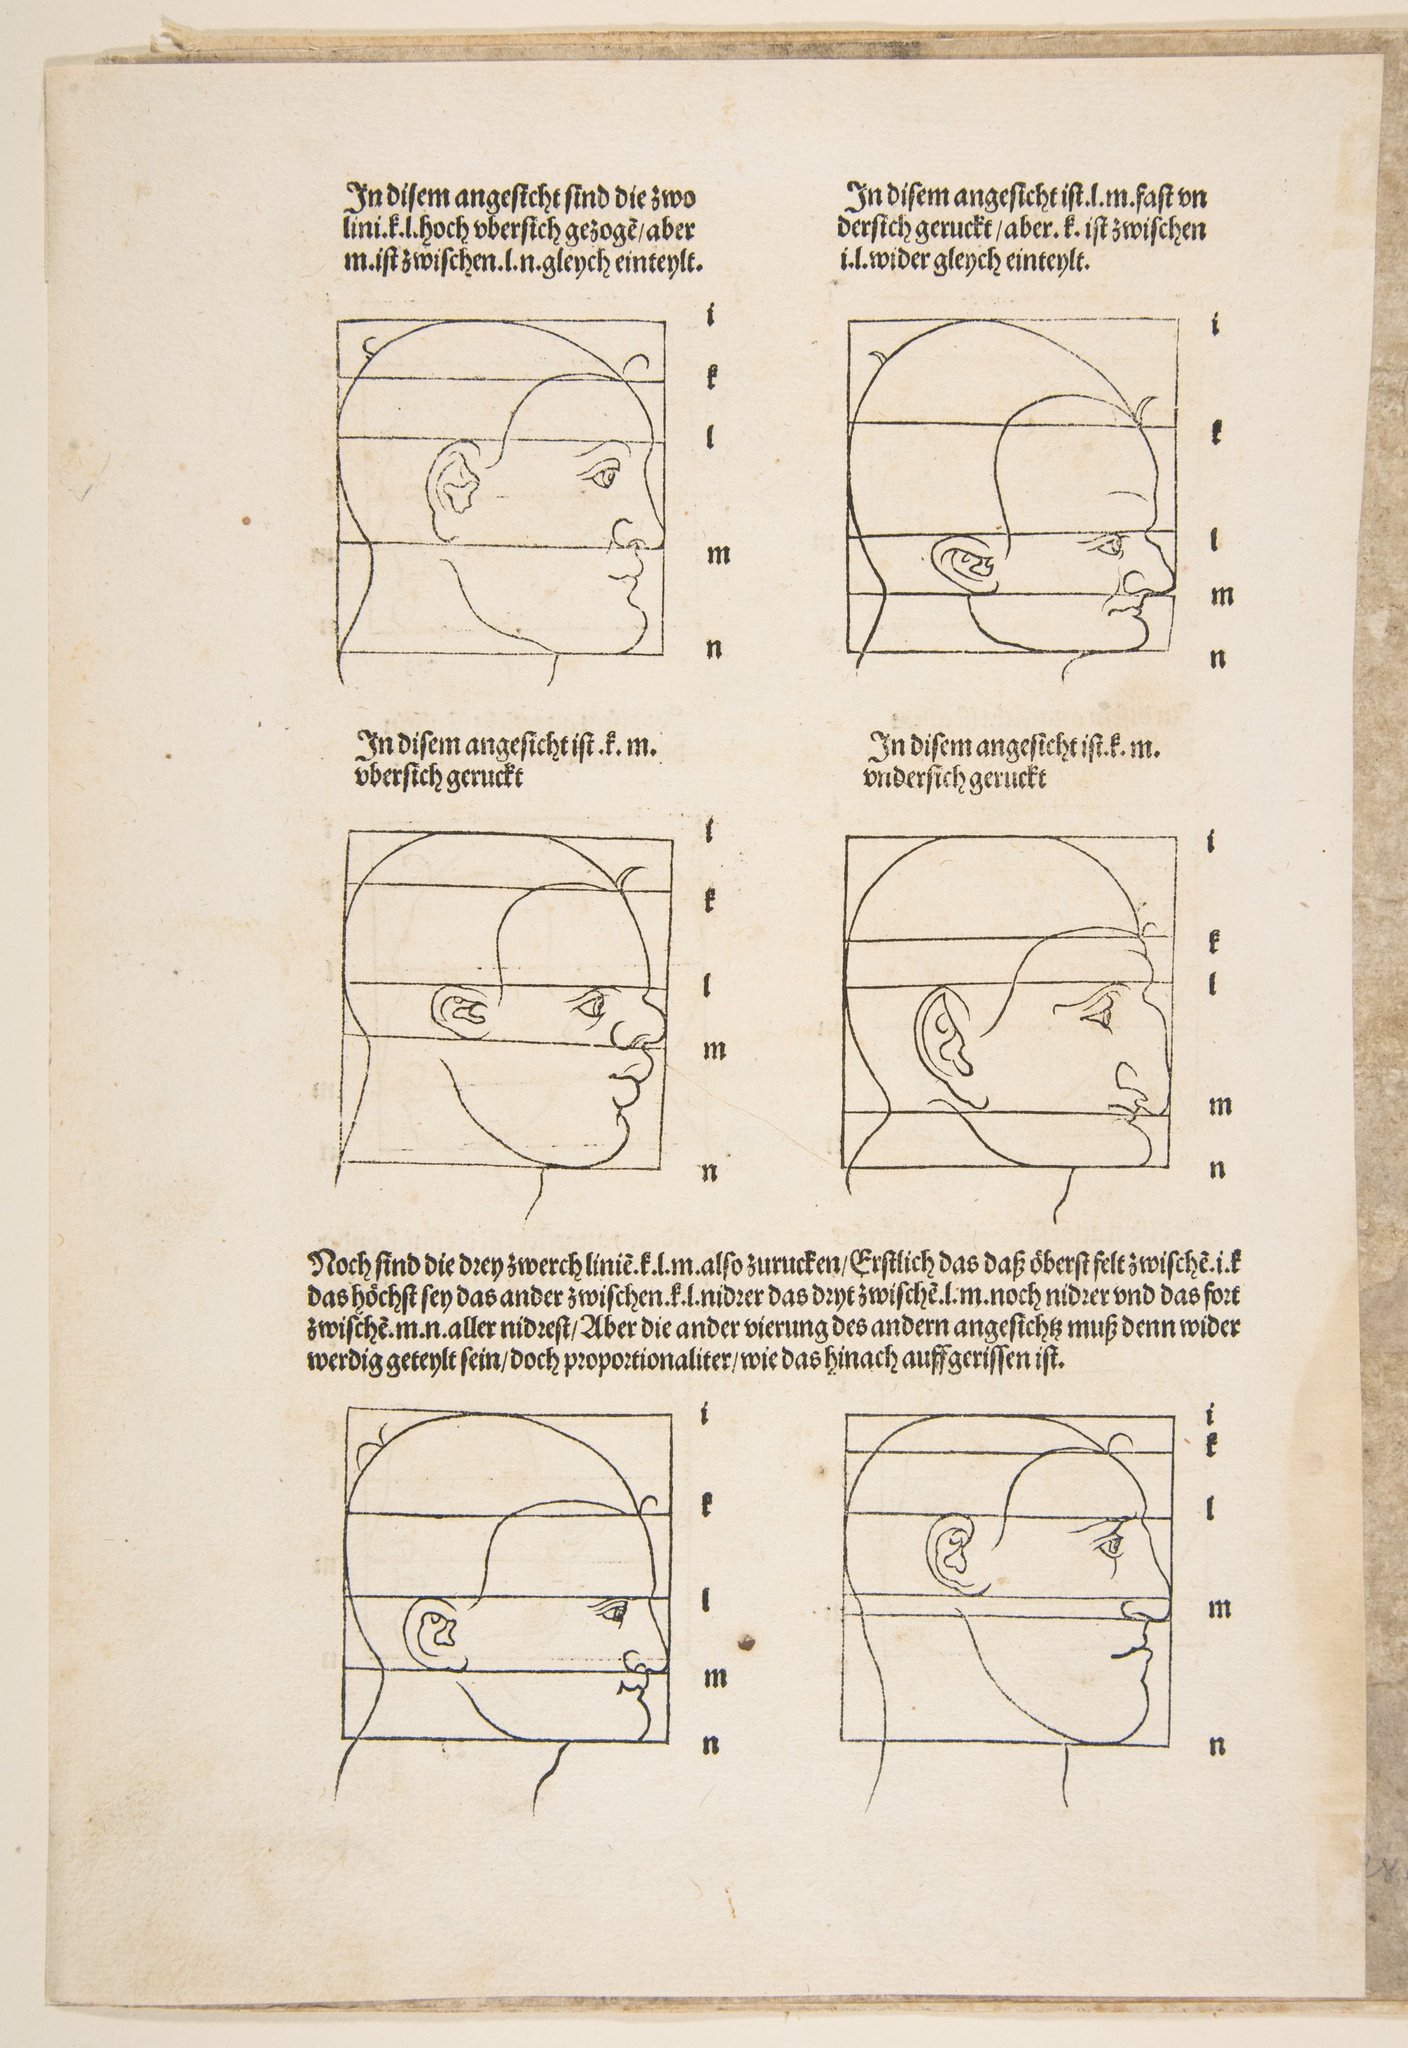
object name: print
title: Illustration and Text from Dürer's "Vier Bucher von Menslicher Proportion"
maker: albrecht dürer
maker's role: artist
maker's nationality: german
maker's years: 1471-1528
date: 1528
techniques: woodcut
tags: heads,men